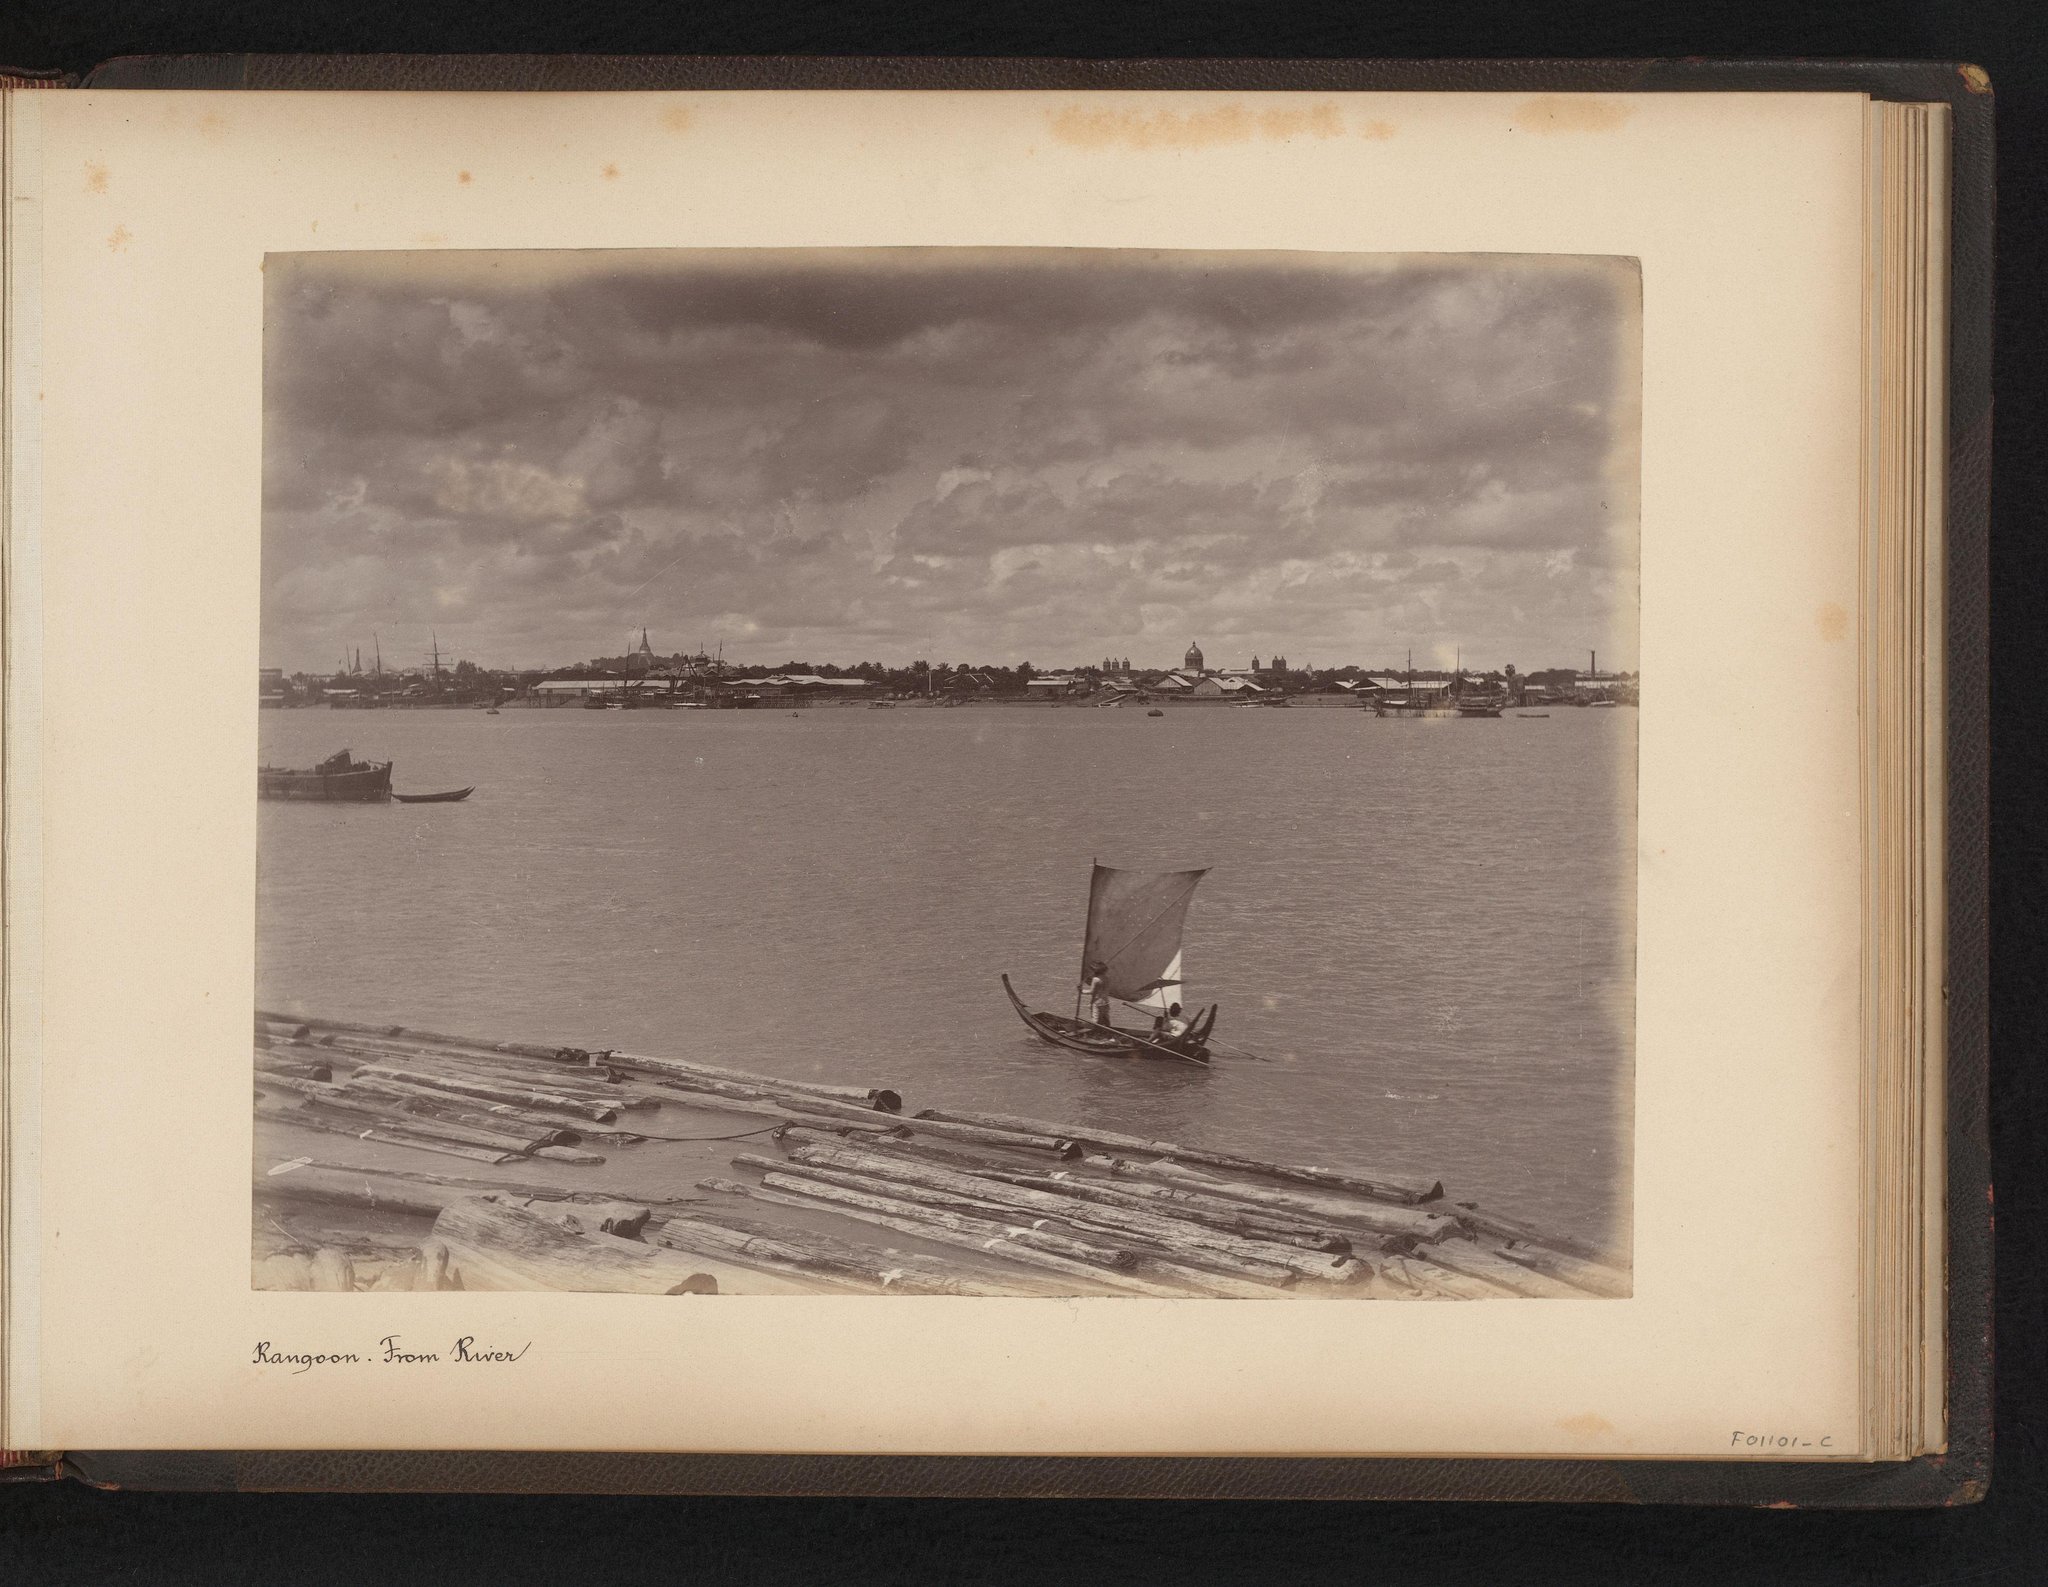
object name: photograph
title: Yangon seen across the river with a sailboat and floating logs in the foreground, Myanmar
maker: philip adolphe klier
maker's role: fotograaf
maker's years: 1845-1911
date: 1885-1886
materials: cardboard, paper, photographic support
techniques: albumen print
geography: yangon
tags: river (+ landscape with figures, staffage), prospect of city, town panorama, silhouette of city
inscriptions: caption: ‘Rangoon. From River’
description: Onderdeel van Reisalbum met foto's van bezienswaardigheden in Birma.